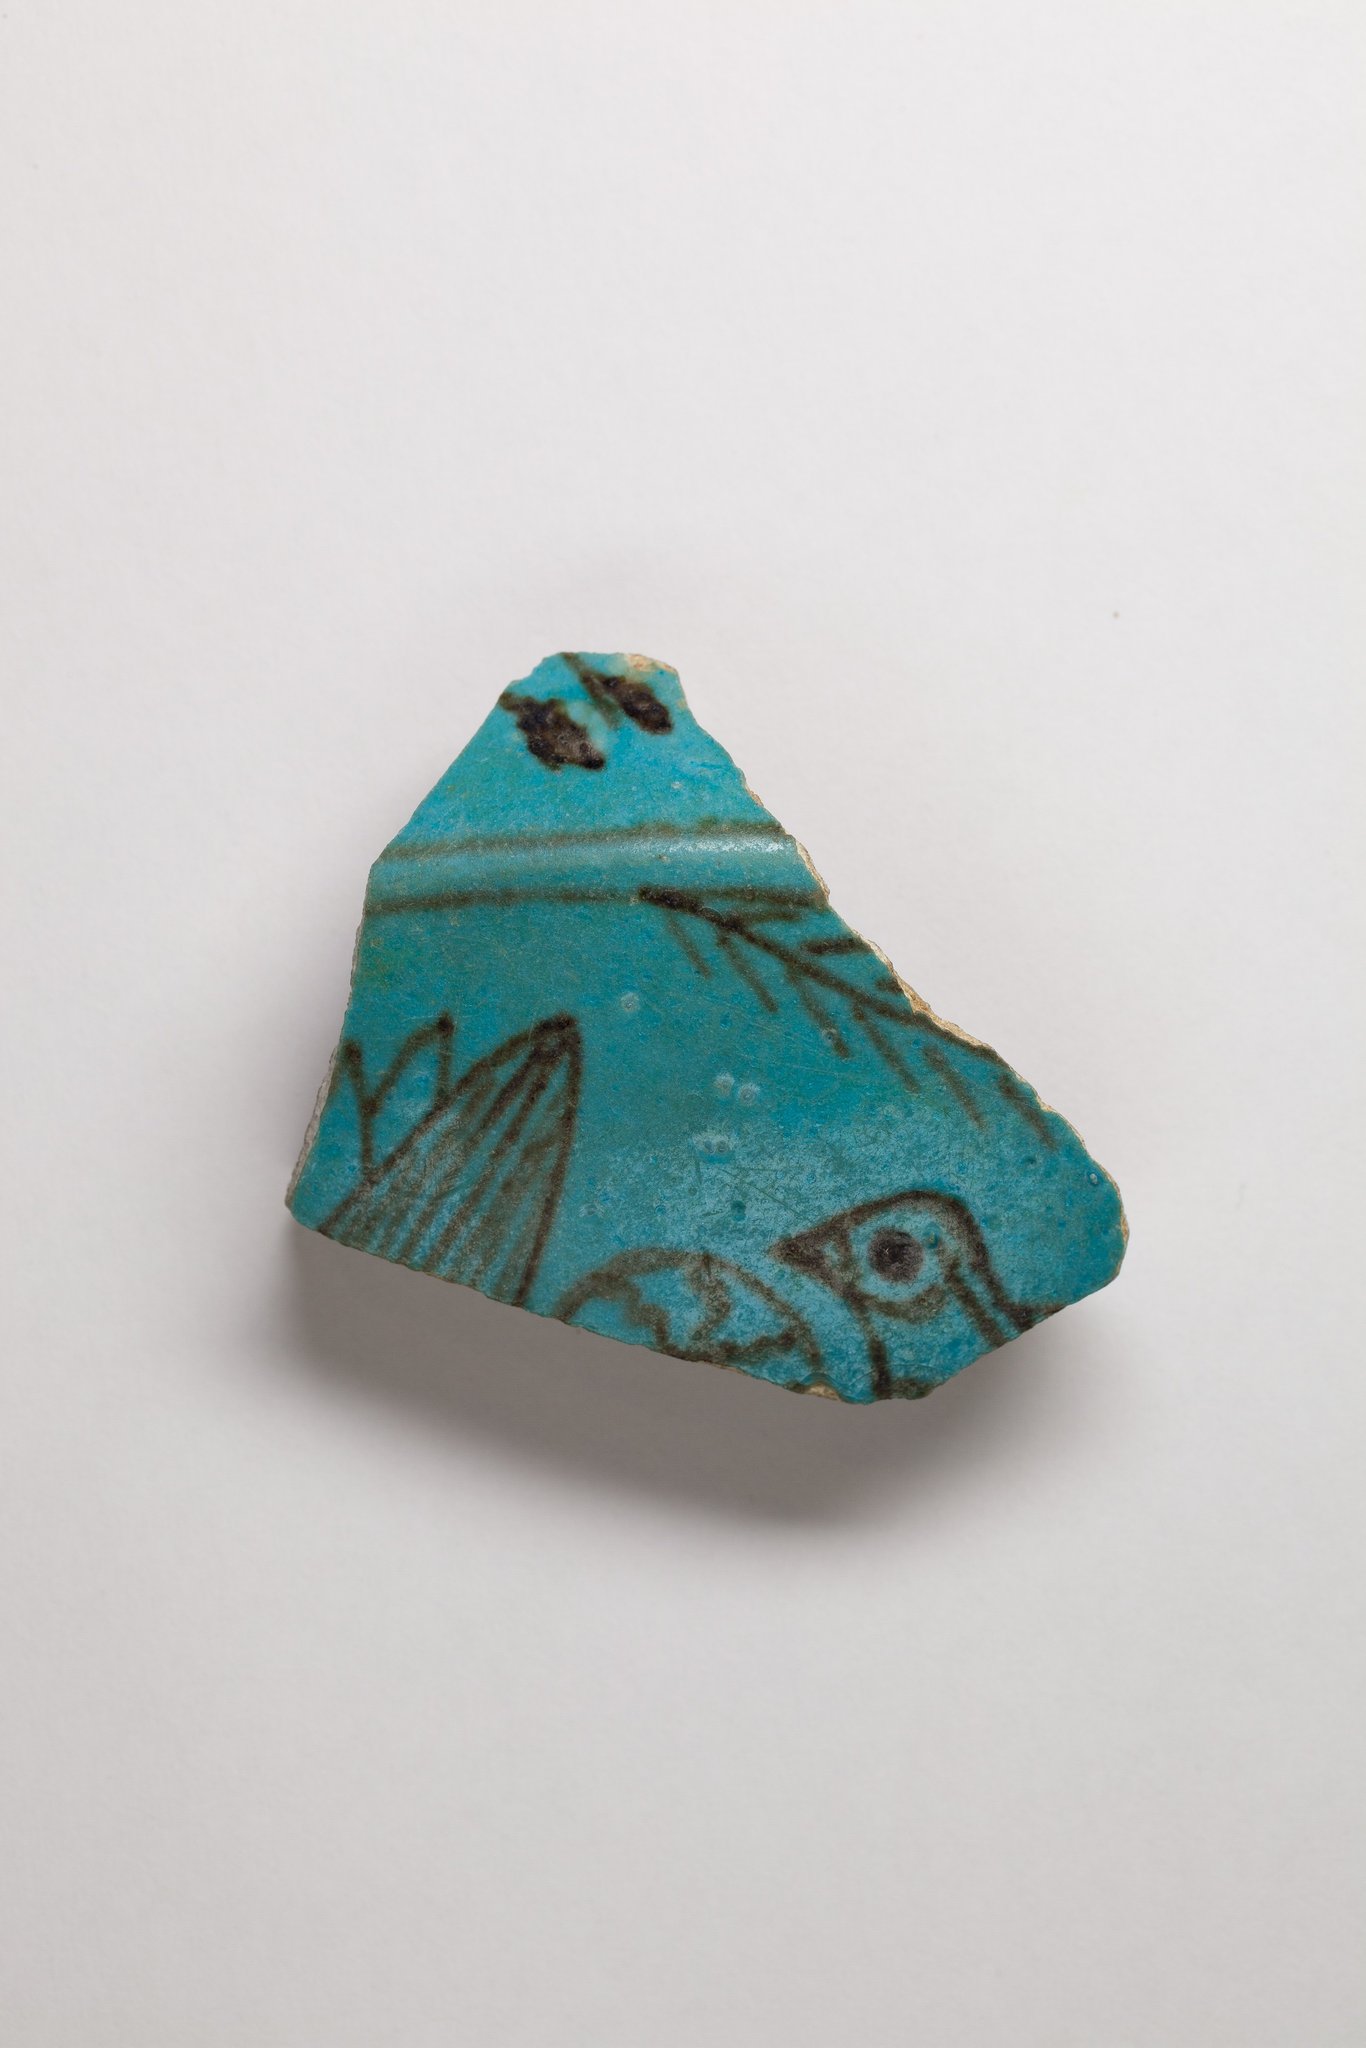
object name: bowl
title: Decorated Bowl Fragment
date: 1981-1640 BCE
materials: faience, paint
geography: egypt